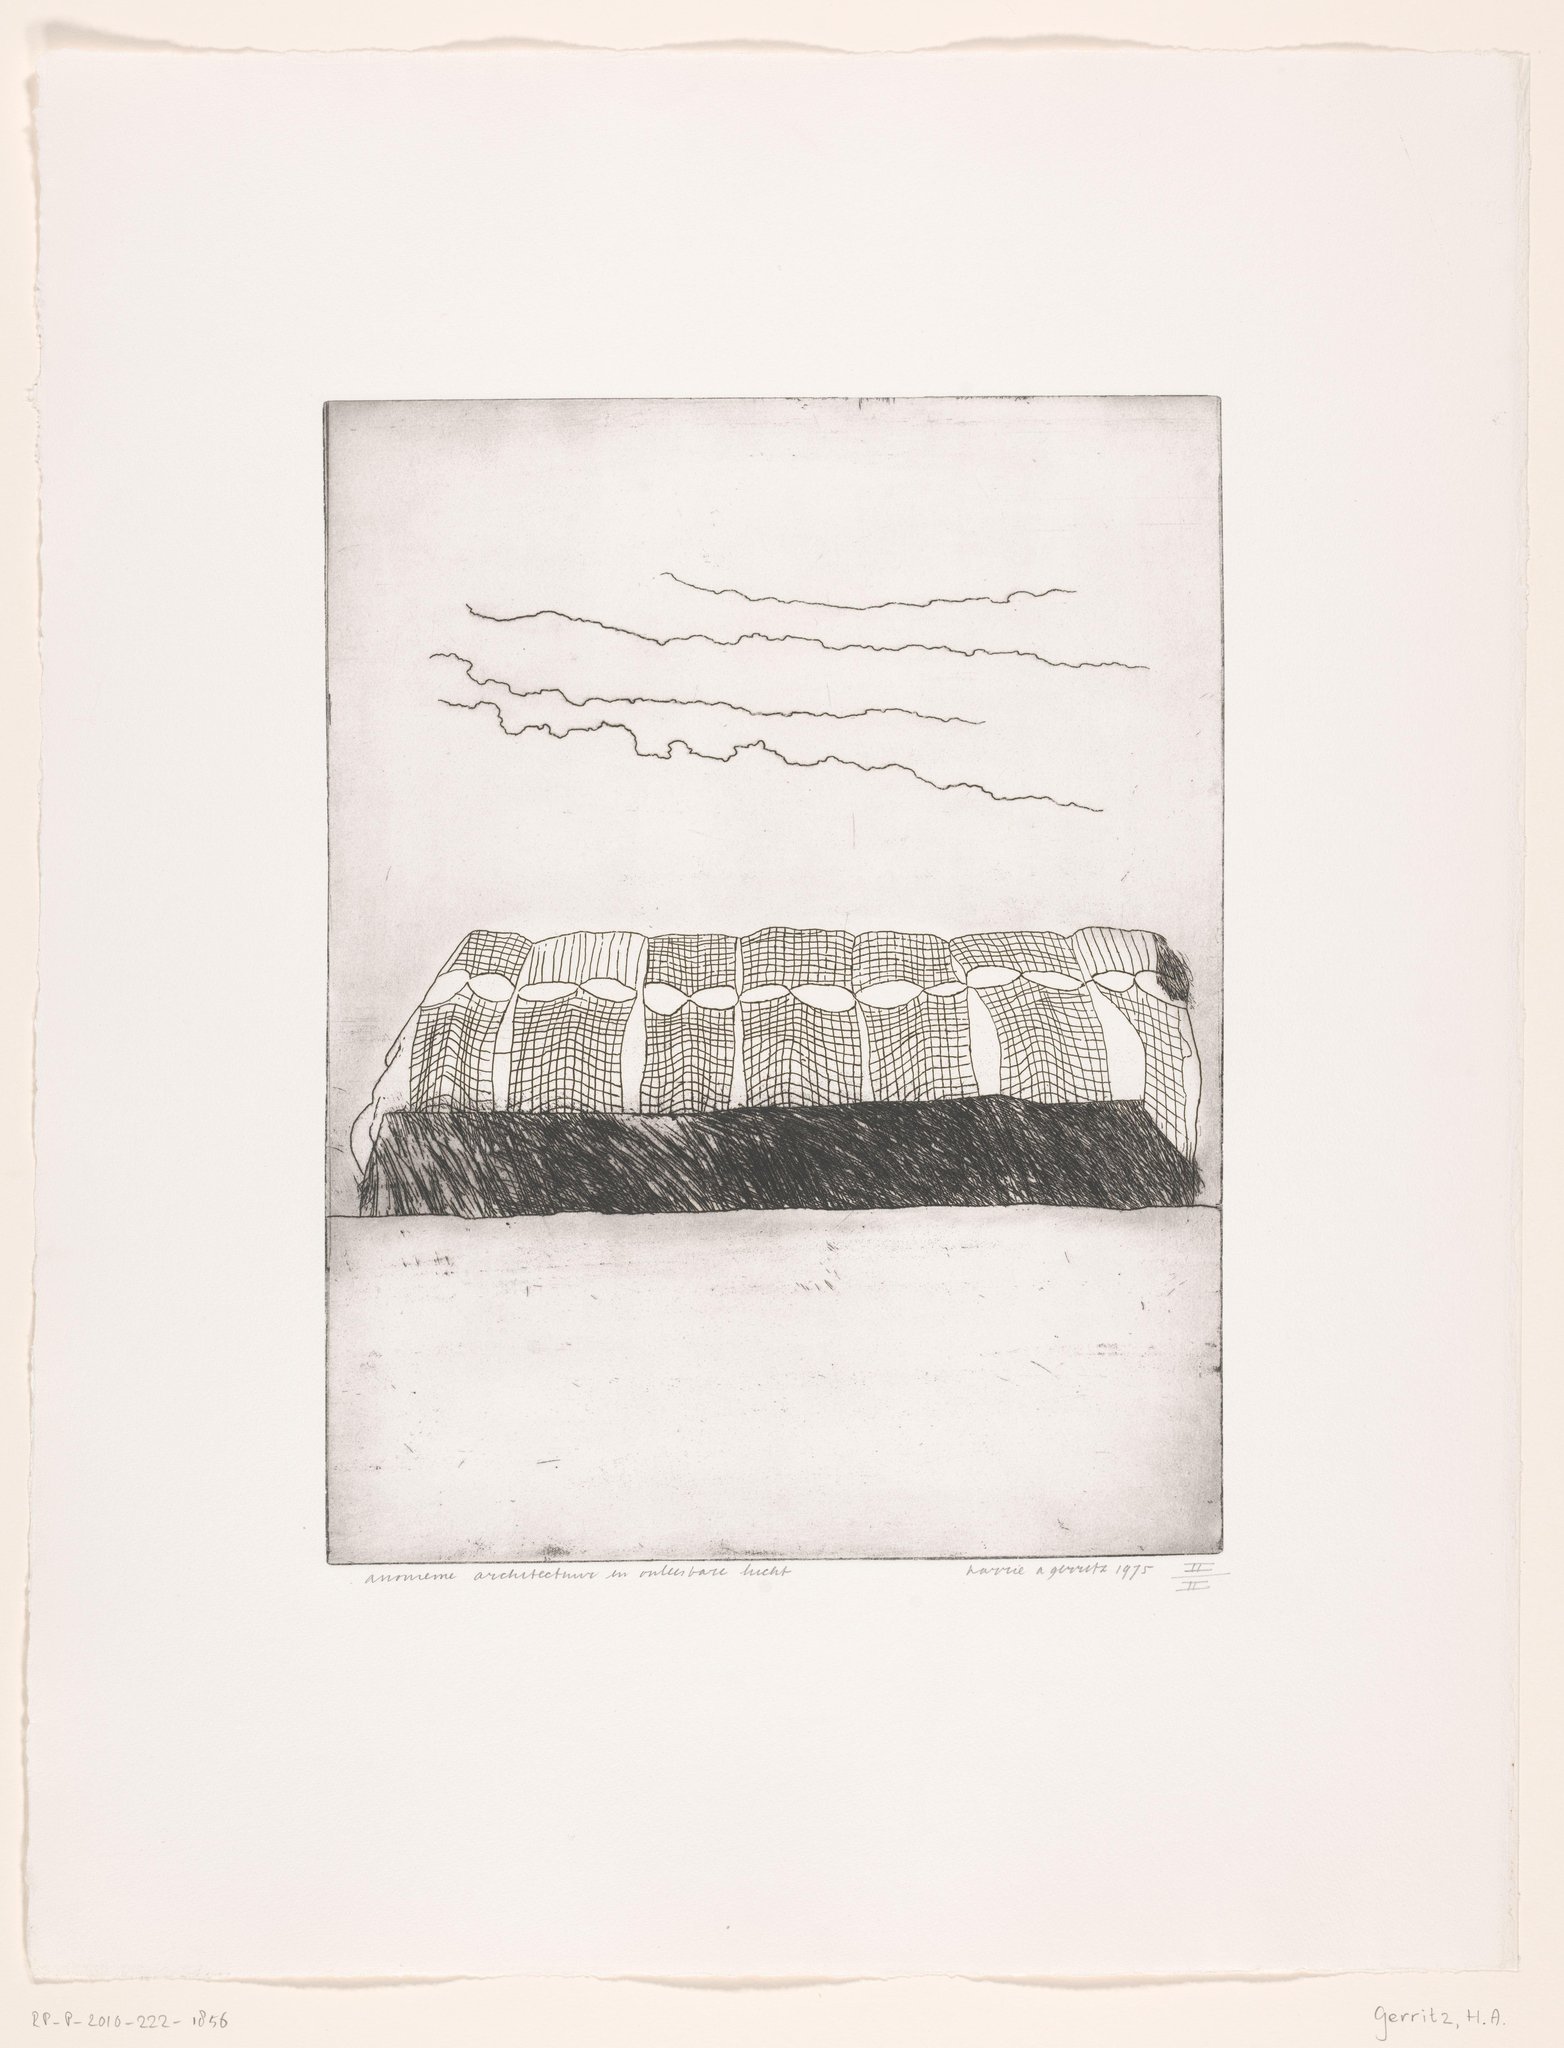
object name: print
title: Anonieme architectuur in onleesbare lucht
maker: harrie a. gerritz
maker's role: draughtsman, painter, print maker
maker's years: 1940-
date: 1975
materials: paper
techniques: etching, intaglio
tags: air (one of the four elements), fantastic architecture, unrealistic architectural fantasies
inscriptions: collector's mark: Lugt 2228, inscription: ‘PC’